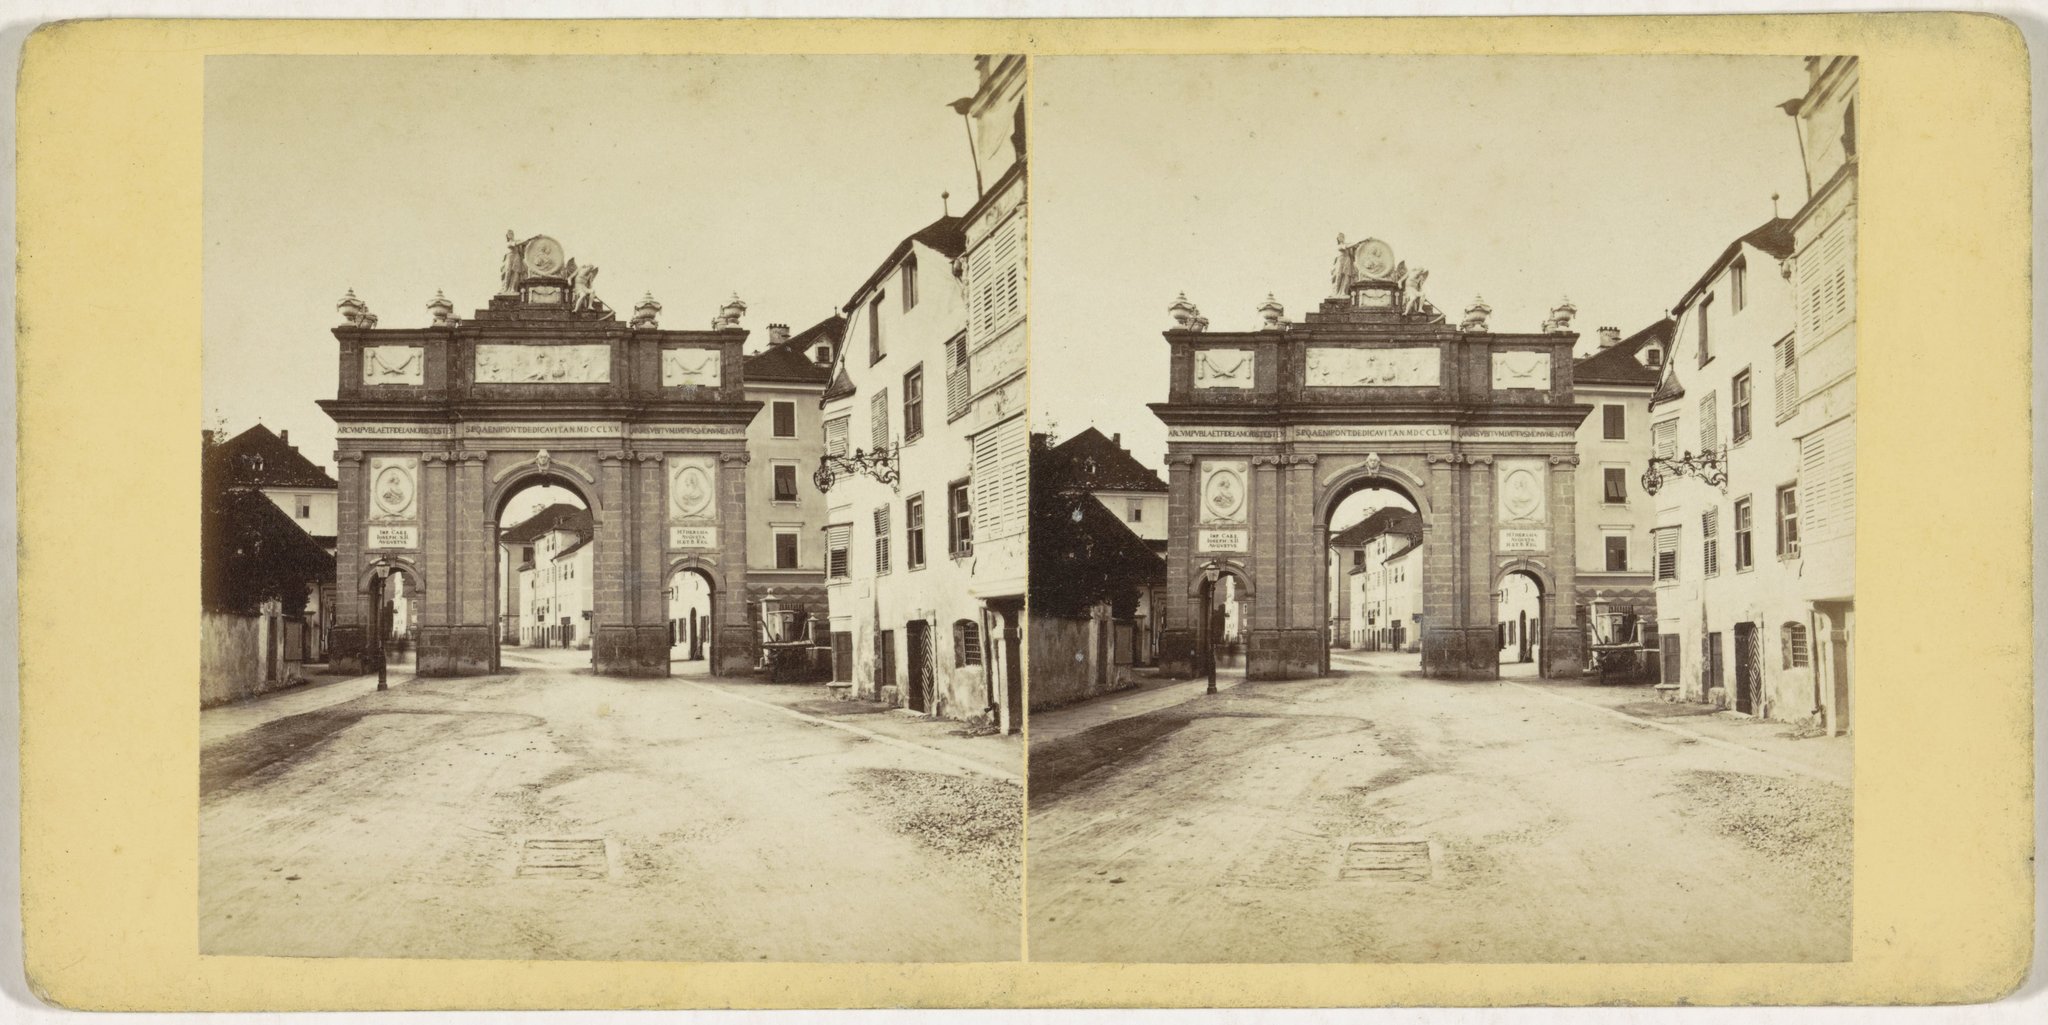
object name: stereograph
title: Noordzijde van de triomfboog in Innsbruck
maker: johann friedrich stiehm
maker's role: fotograaf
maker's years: 1826-1902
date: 1868-1890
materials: cardboard, paper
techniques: albumen print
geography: london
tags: triumphal arch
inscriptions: number: ‘No. 64’